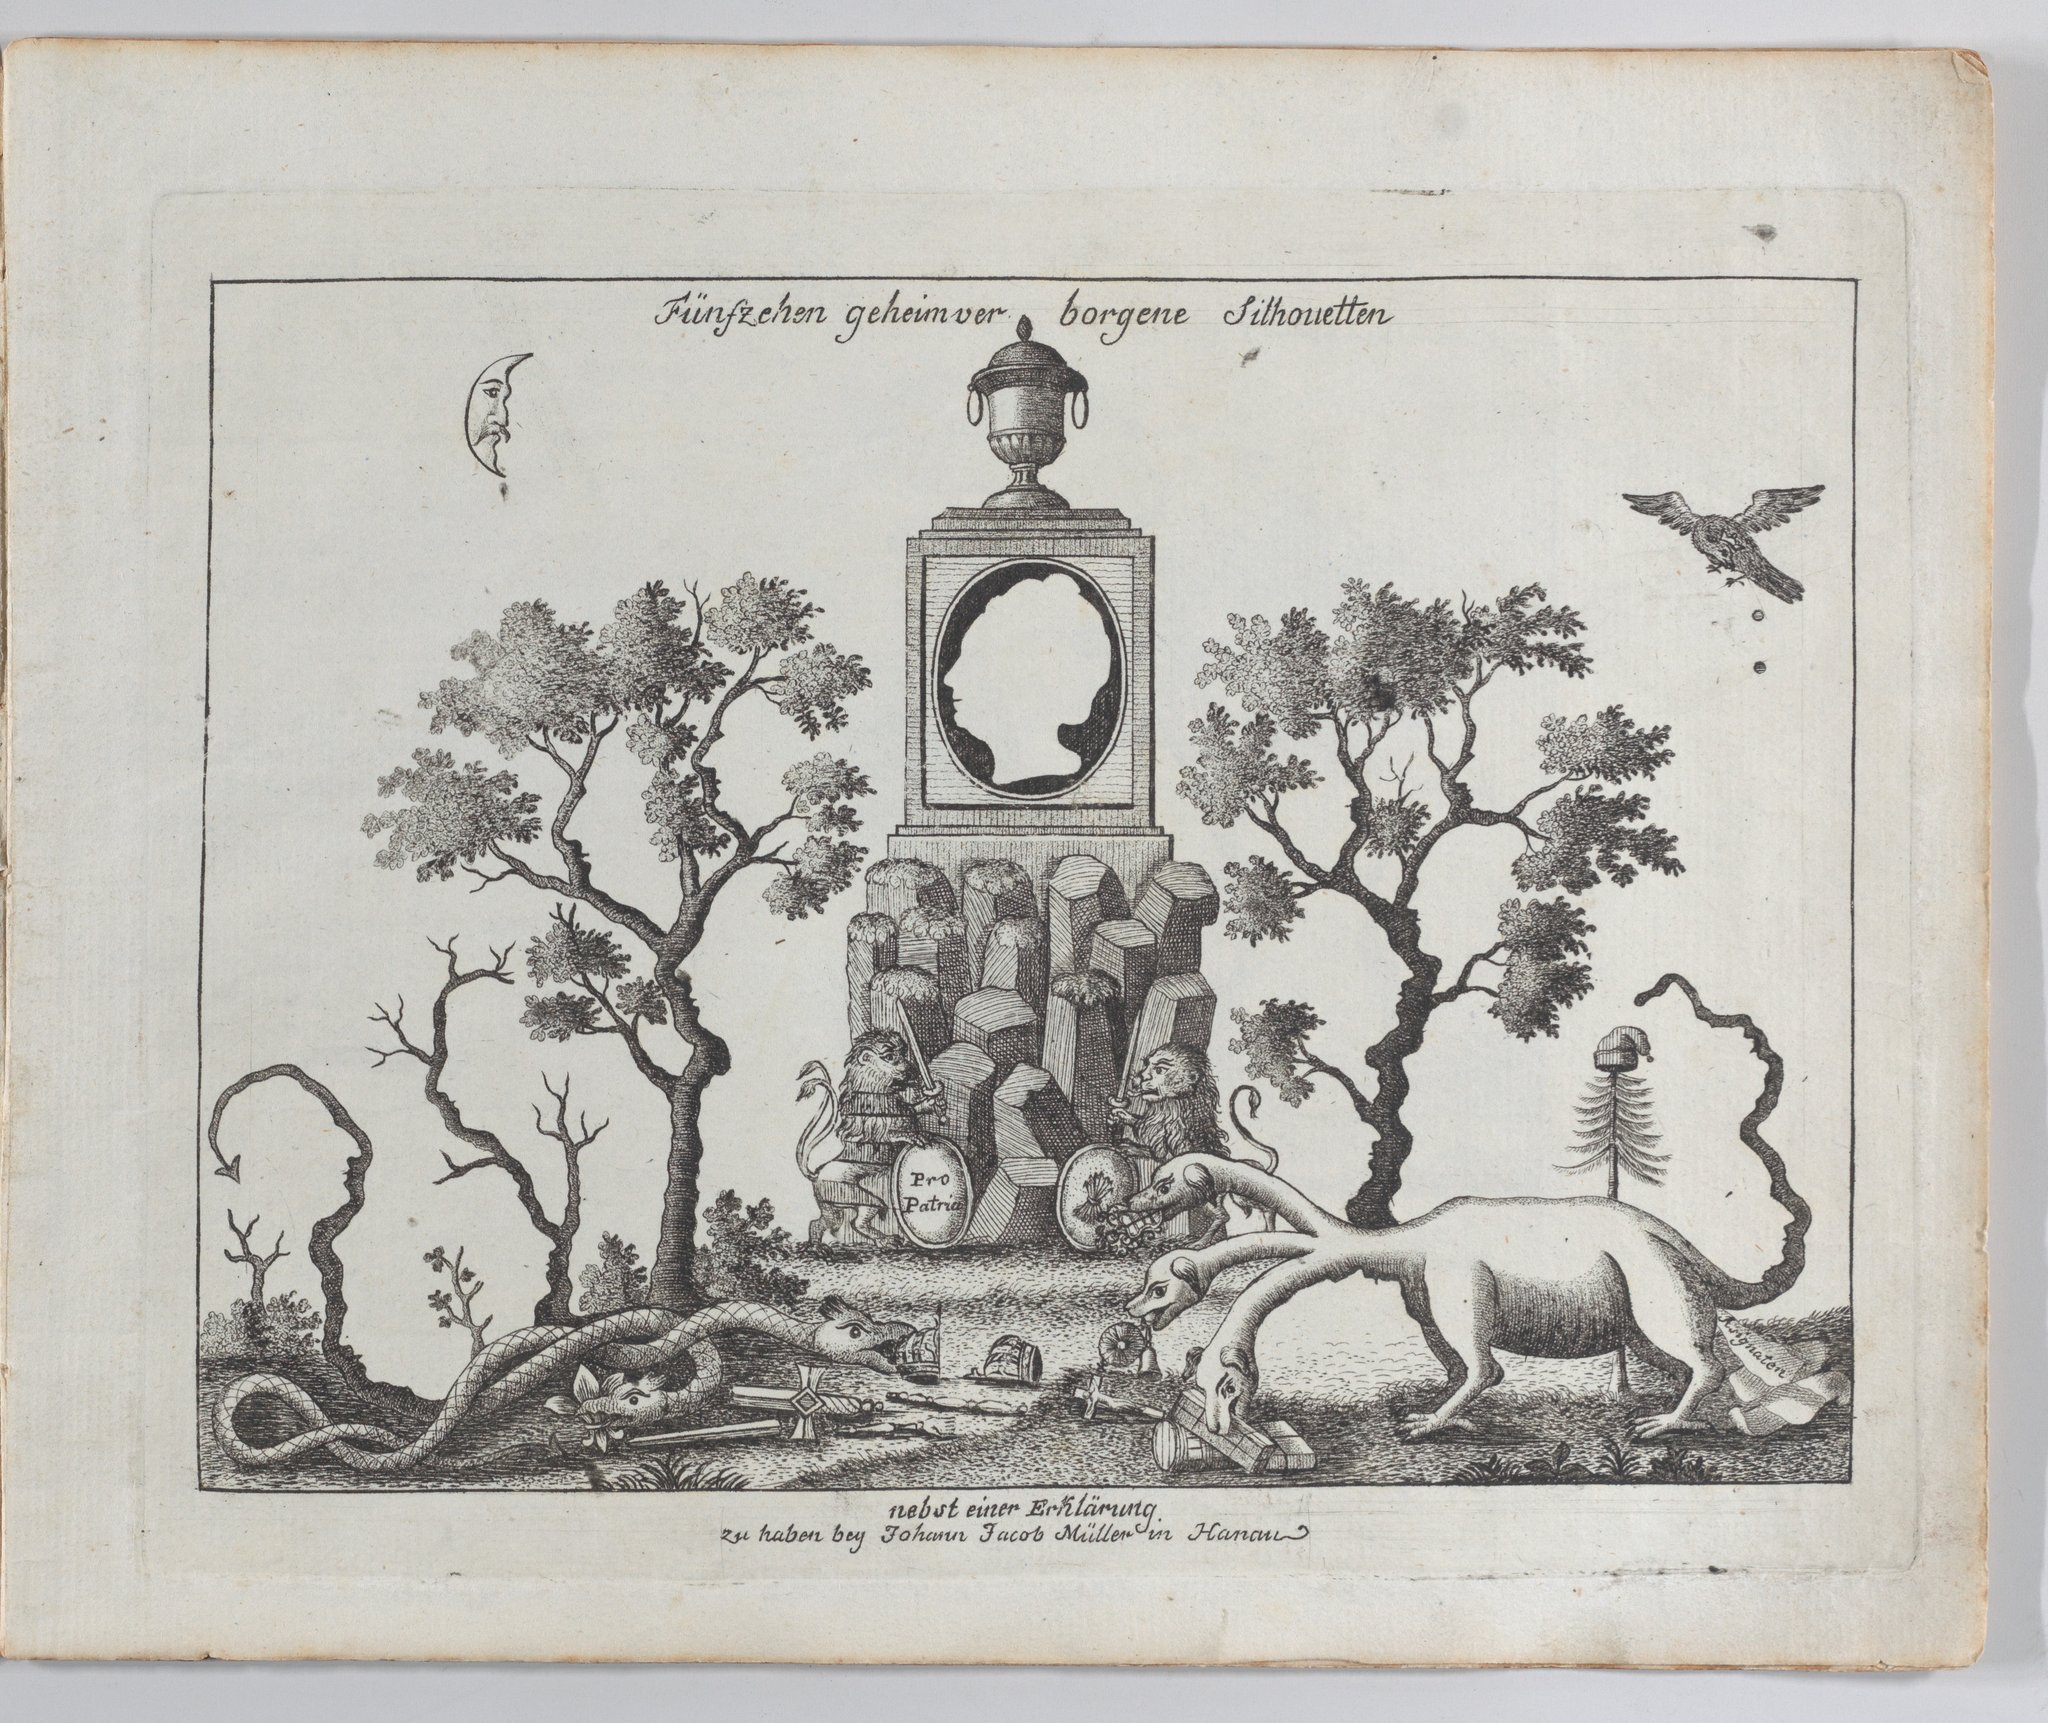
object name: album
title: Landscape containing fifteen silhouettes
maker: anonymous, german, 18th century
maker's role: artist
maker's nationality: german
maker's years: 1700-1800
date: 1793-1800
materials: crayon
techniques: etching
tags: kings,queens,mythical creatures,lions,snakes